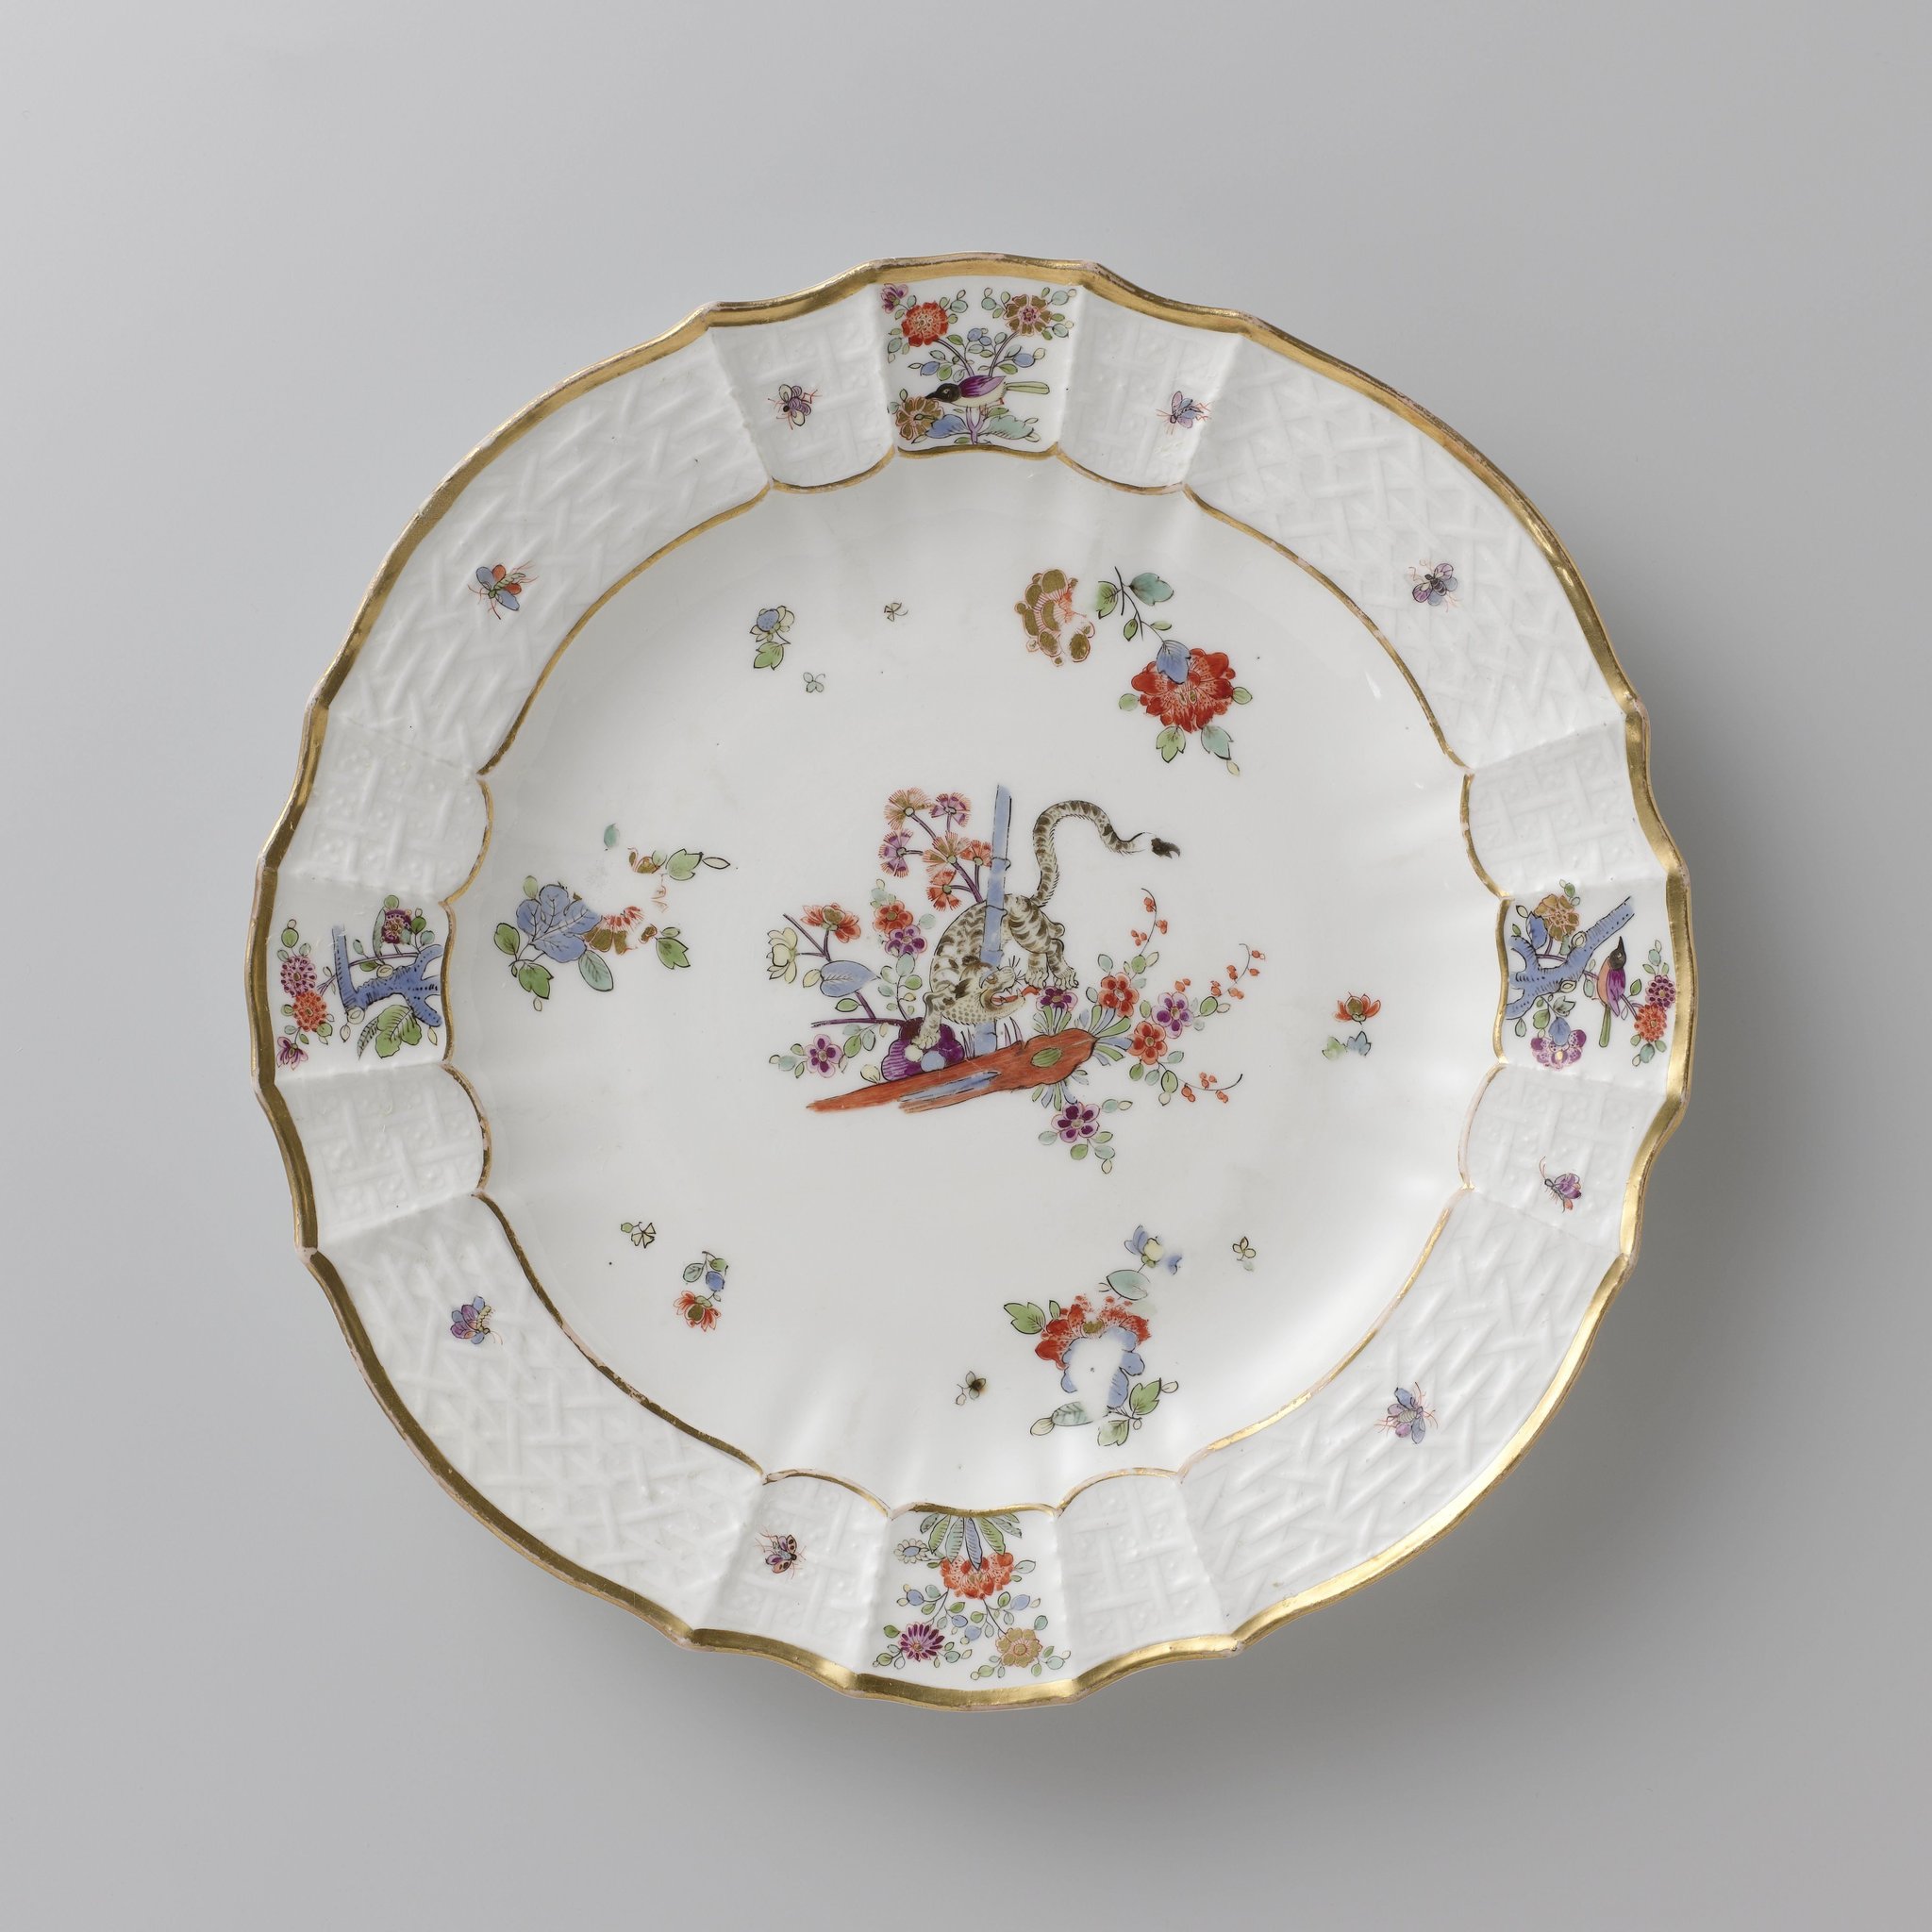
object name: plate dish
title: Rond bord, veelkleurig beschilderd met een Kakiemon-decor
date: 1740-1745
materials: porcelain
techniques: painted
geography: meissen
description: Rond bord van beschilderd porselein. Het bord is geribd en heeft een geschulpte rand. Het bord is beschilderd met een tijger die om een blauwe bamboestengel tussen bloemen is gedraaid, gestrooide Indianische Blumen, vlinders en takken waarop vogels. De rand is versierd met het 'Altbrandenstein'-patroon. Het bord is gemerkt.